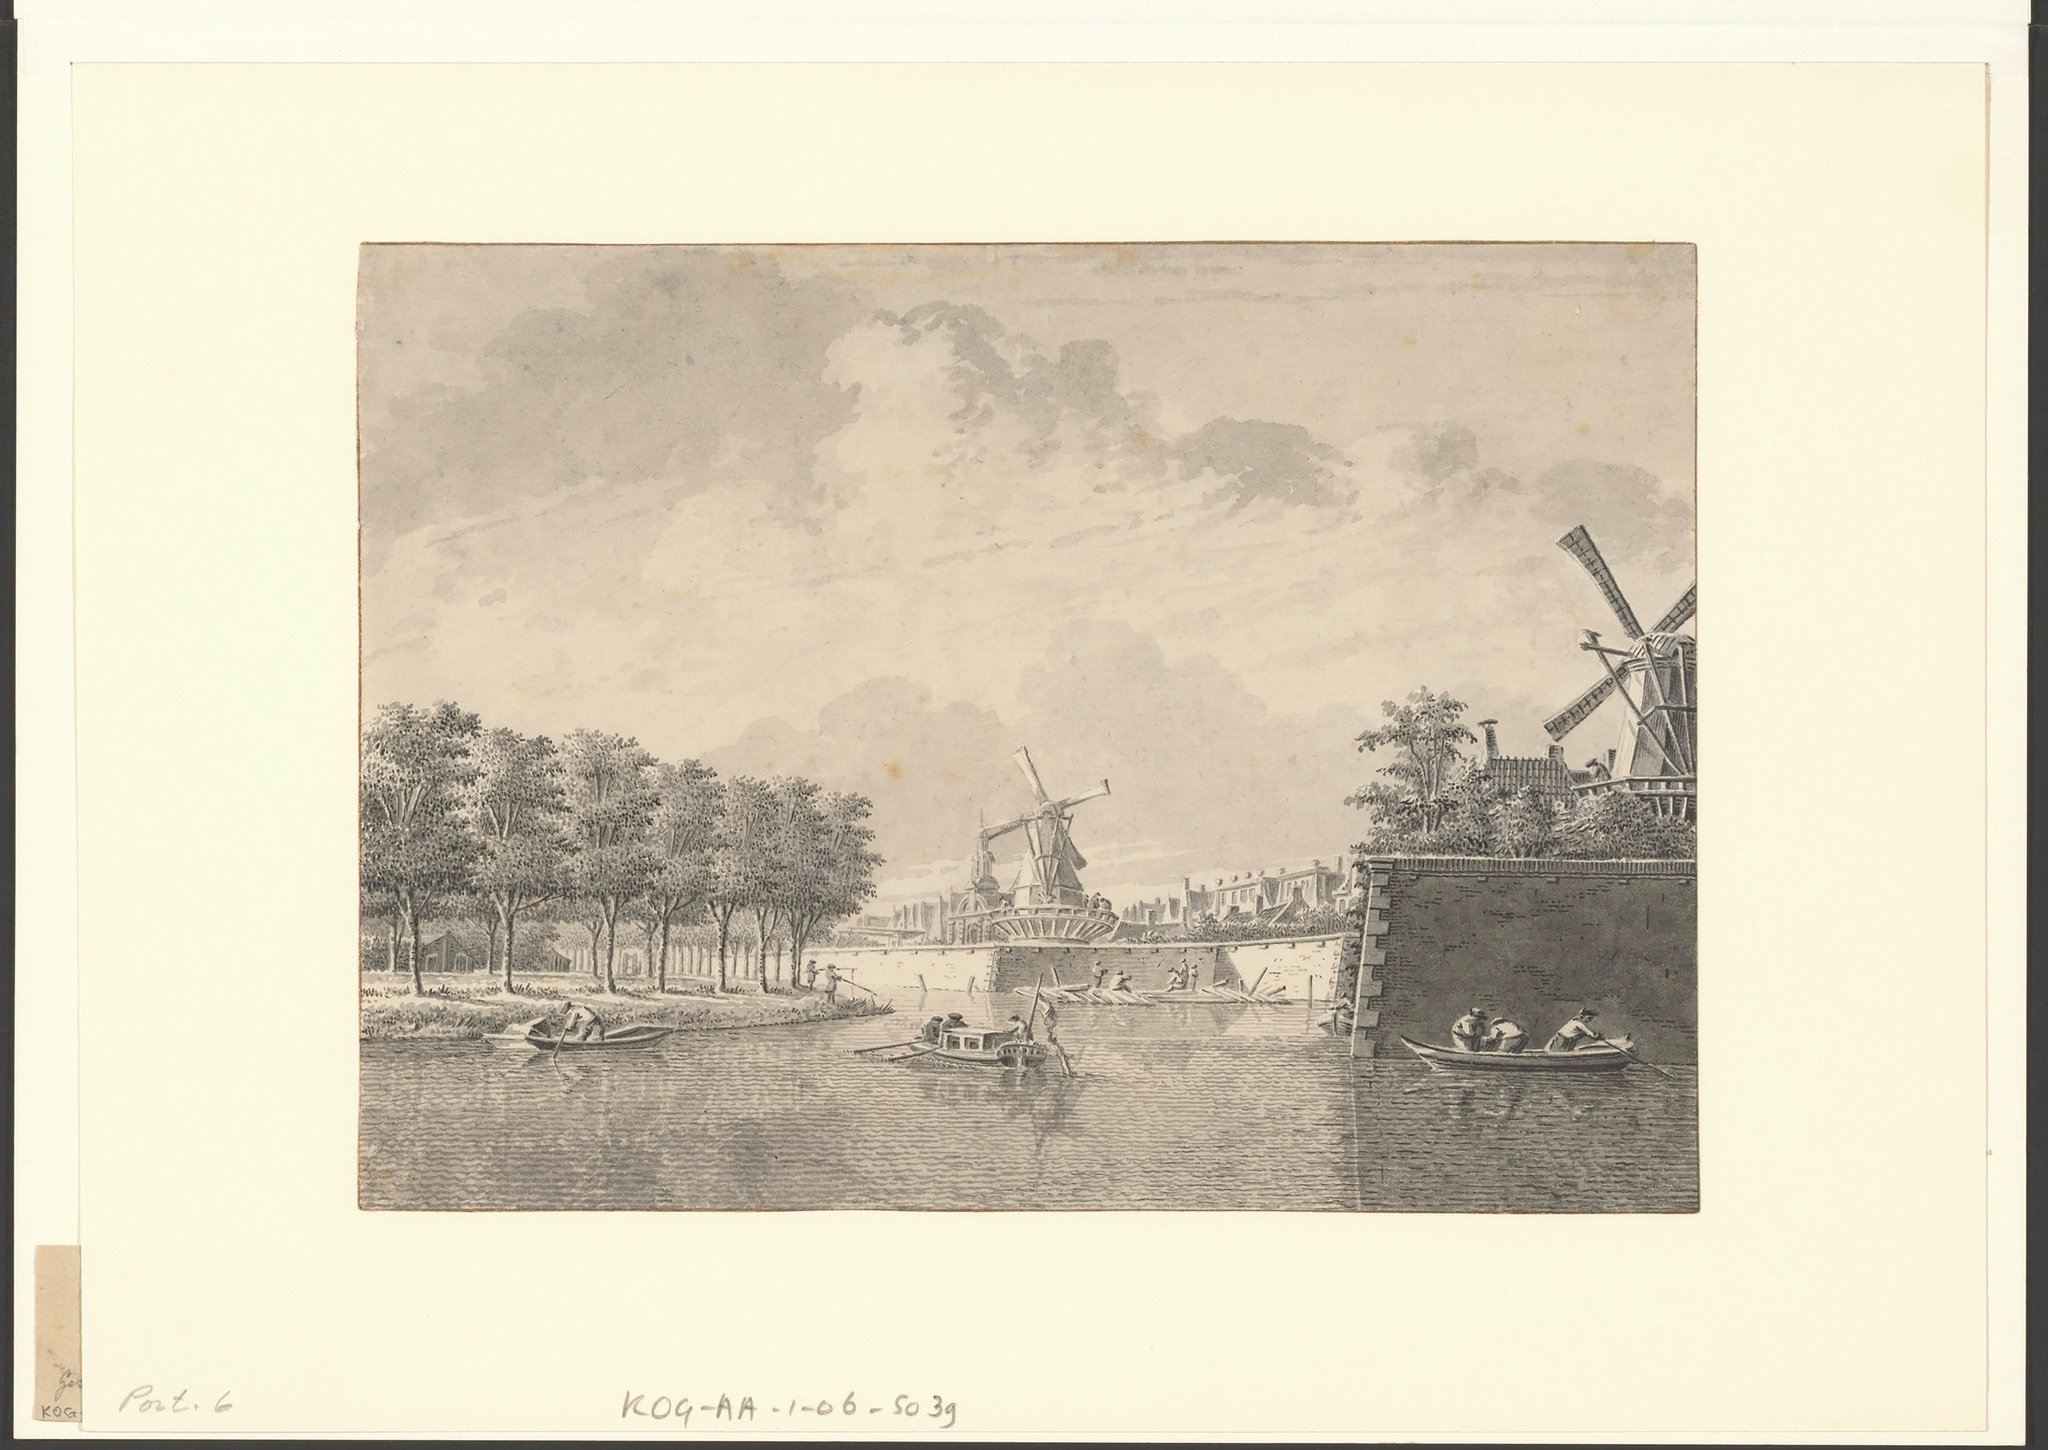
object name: drawing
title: Gezicht op het Singel bij de Haarlemmerpoort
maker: dirk verrijk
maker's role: draughtsman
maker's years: 1734-1786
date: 1744-1786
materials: ink, paper, pencil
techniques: brush, pen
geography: amsterdam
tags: city-view in general; 'veduta', river, windmill in landscape, city-gate, boat propelled by man or animal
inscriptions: inscription: ‘Port. 6’, inscription: ‘Buiten singel b/d Haarlemmerpoort’, collector's mark: ‘6’ Lugt 1641b, inscription: ‘Geschenk v/d Heer Koch 1882’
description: Onderwerpsrubriek binnen de Atlas Amsterdam: Buitensingel, Gezichten langs en op de Stadsvest van Haarlemmerpoort tot Raampoort.